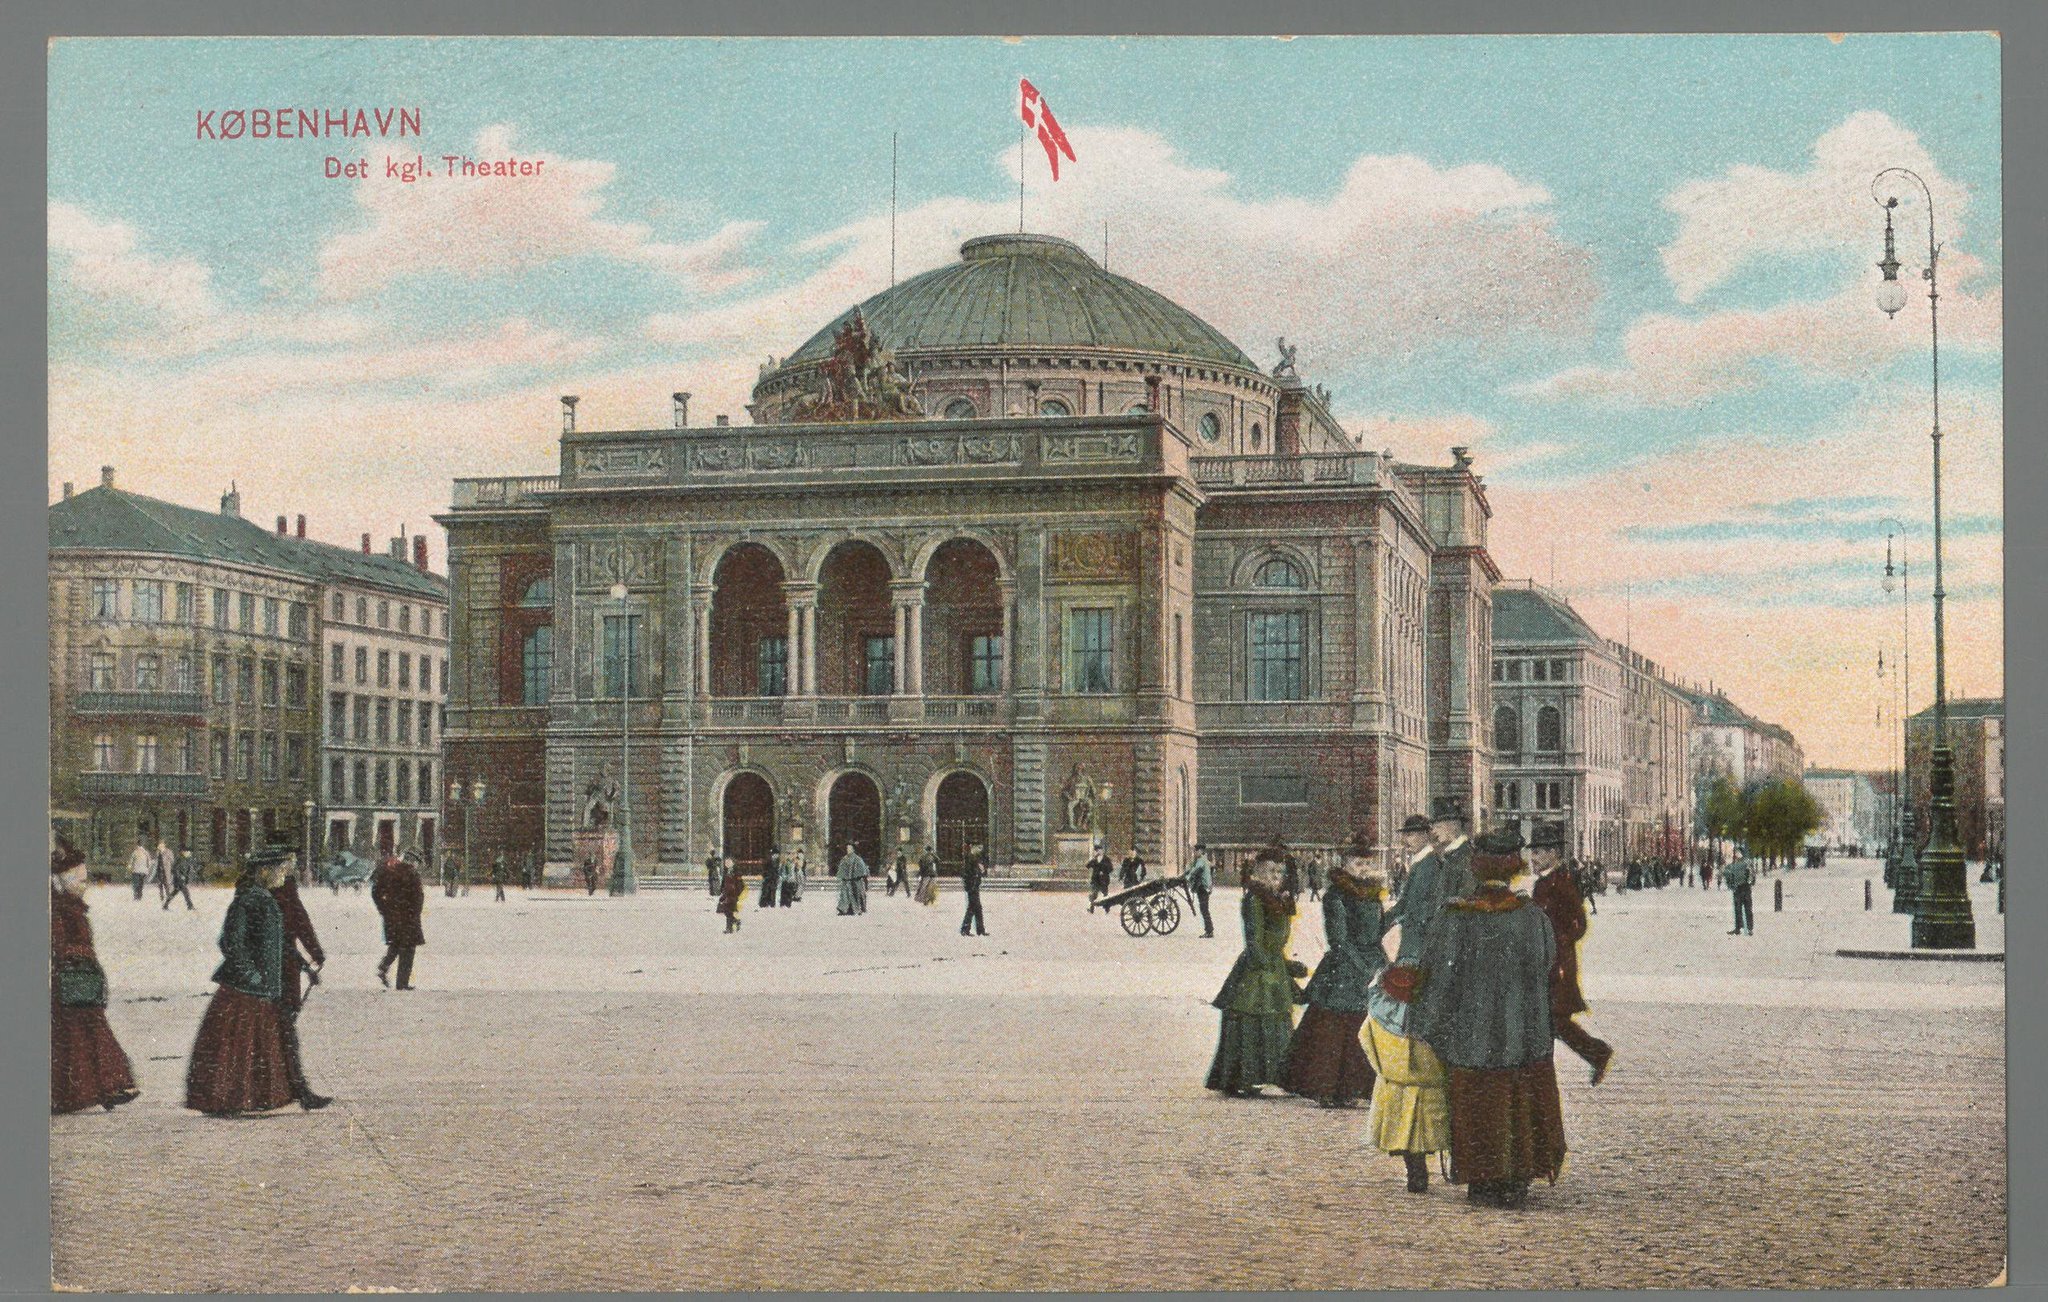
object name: ansichtkaart, prentbriefkaart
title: København. Det kgl. Theater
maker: Anonymous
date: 1906-1920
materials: cardboard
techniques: lithograph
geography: copenhagen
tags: theatre (building) - aa - open-air performances, square, place, circus, etc. (+ city(-scape) with figures, staffage)